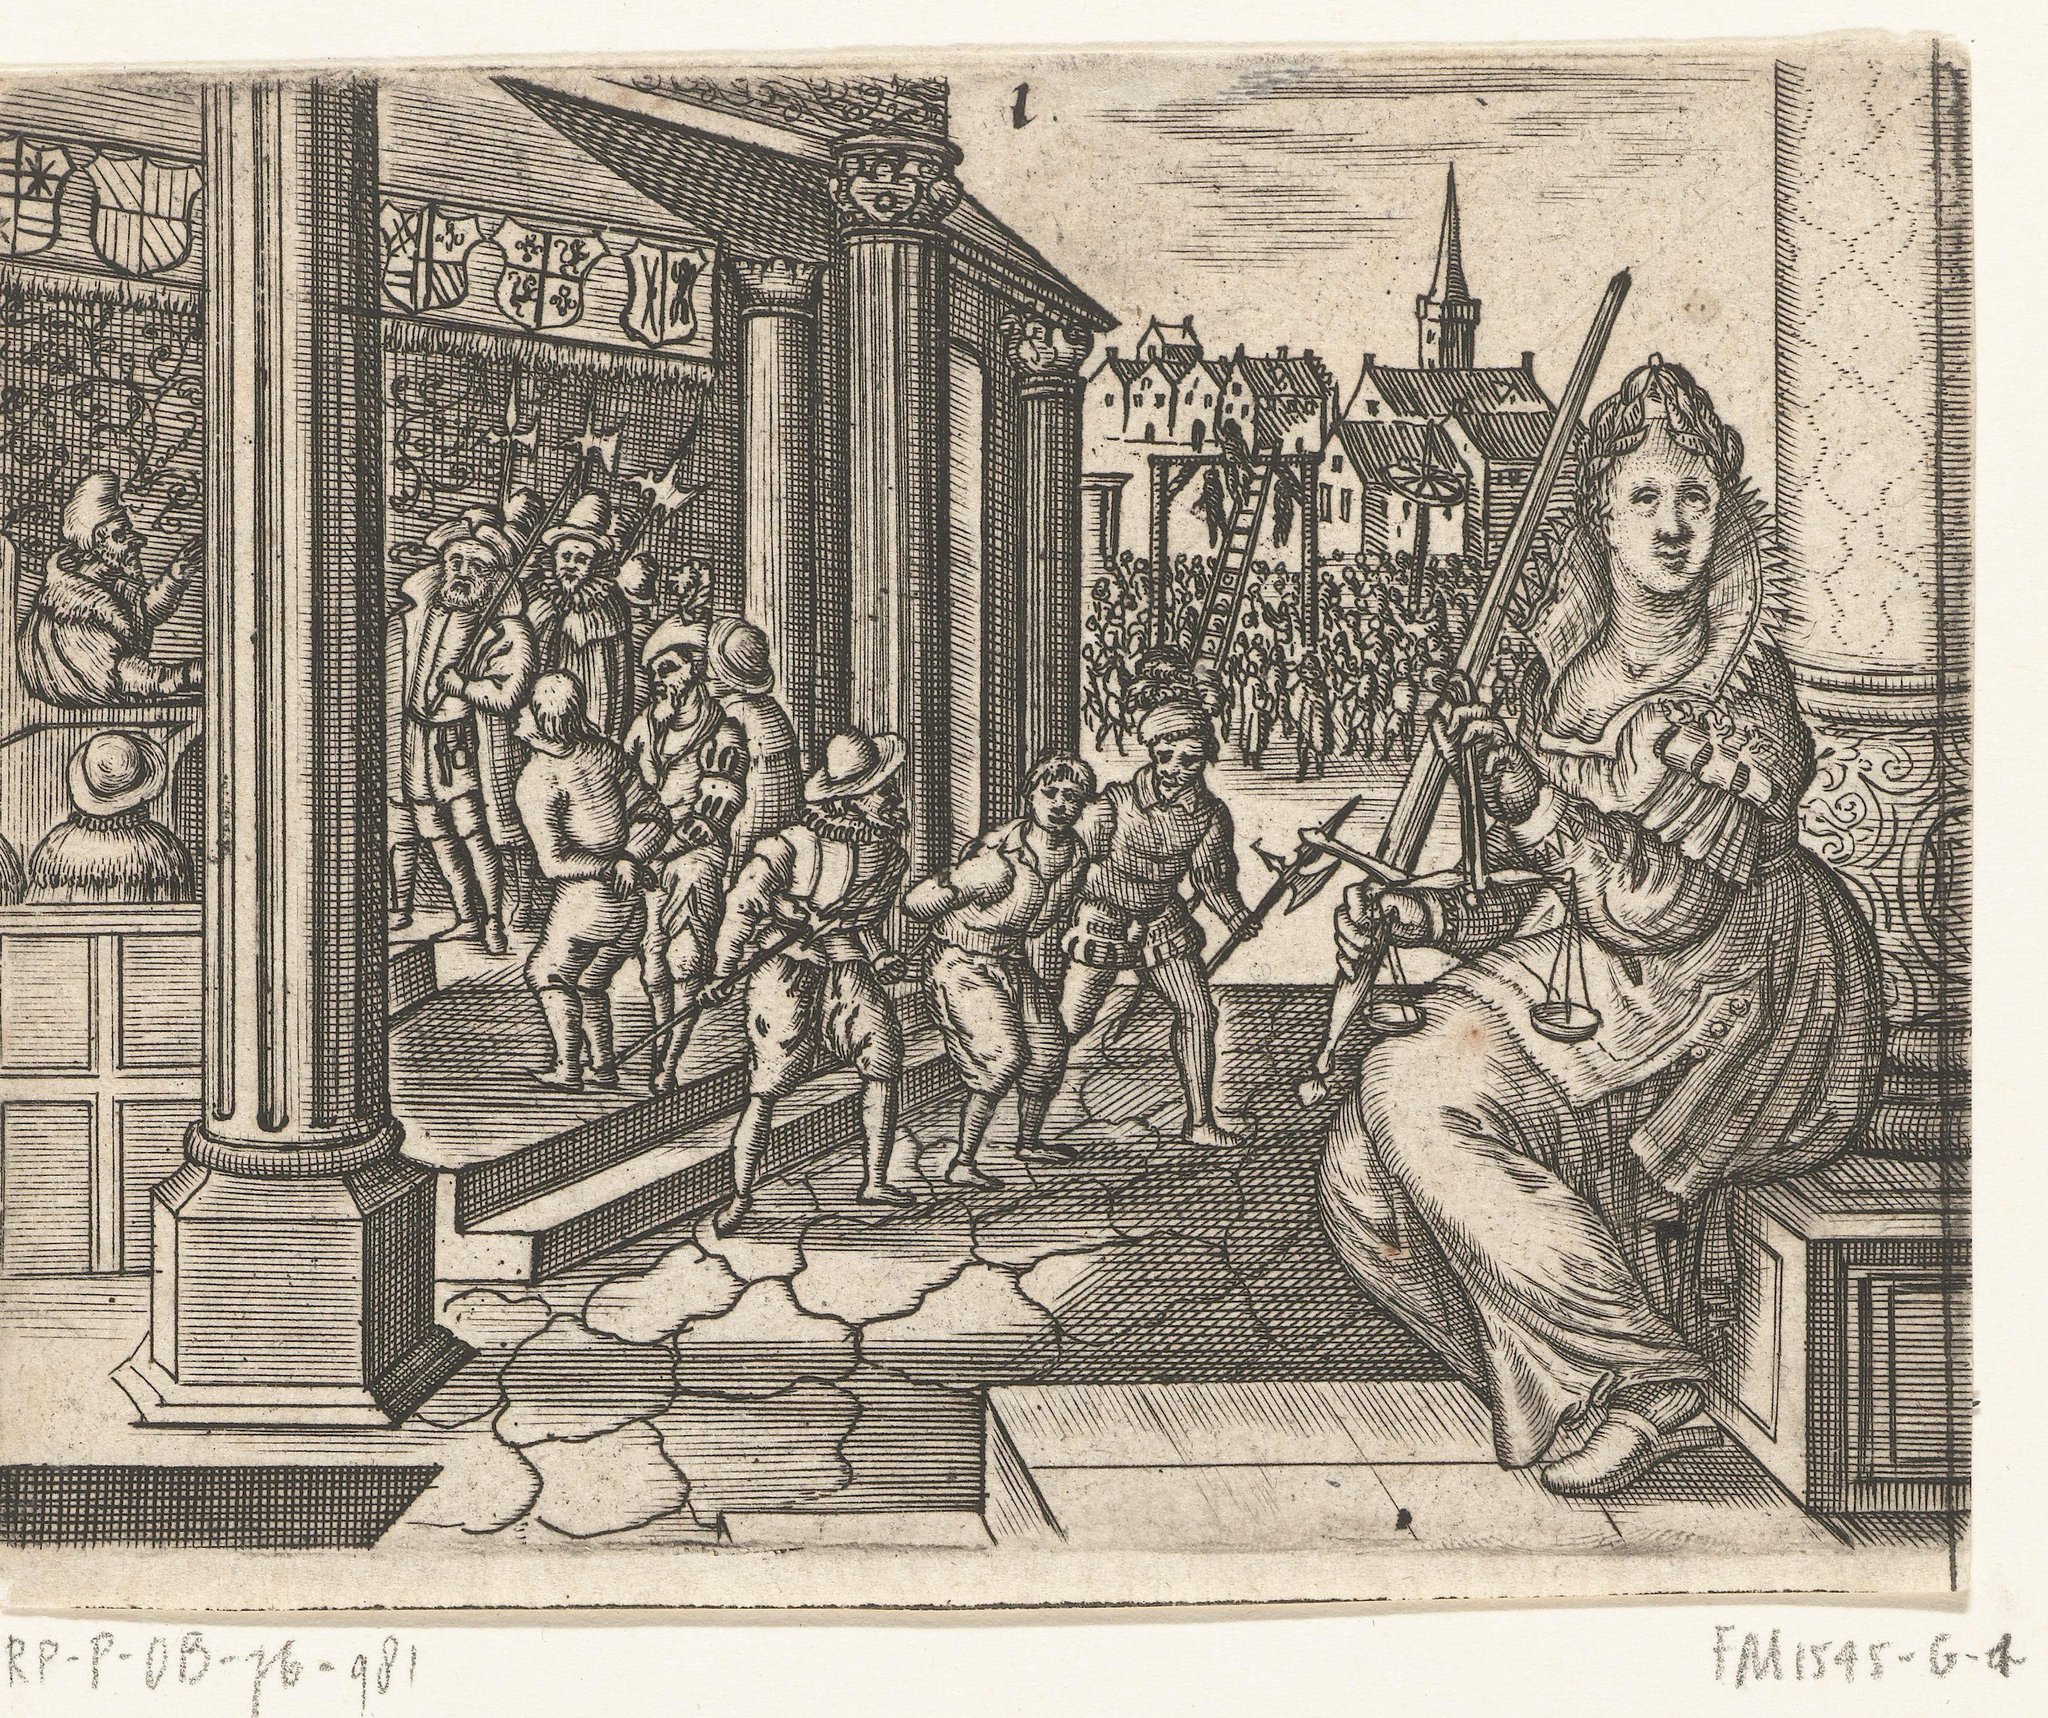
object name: print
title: Politiek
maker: Anonymous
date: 1620-1629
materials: paper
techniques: engraving, letterpress printing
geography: northern netherlands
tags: justice, 'justitia'; 'giustitia divina' (ripa) ~ one of the four cardinal virtues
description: De Politiek. Op de voorgrond rechts zit Vrouwe Justitia met balans, voor een gebouw. Linksachter een gerechtsgebouw met gevangene. Onderdeel van een serie voorstellingen van de Nederlandse maatschappij, ca. 1625. De prent met het bijbehorende vers op een apart blad.